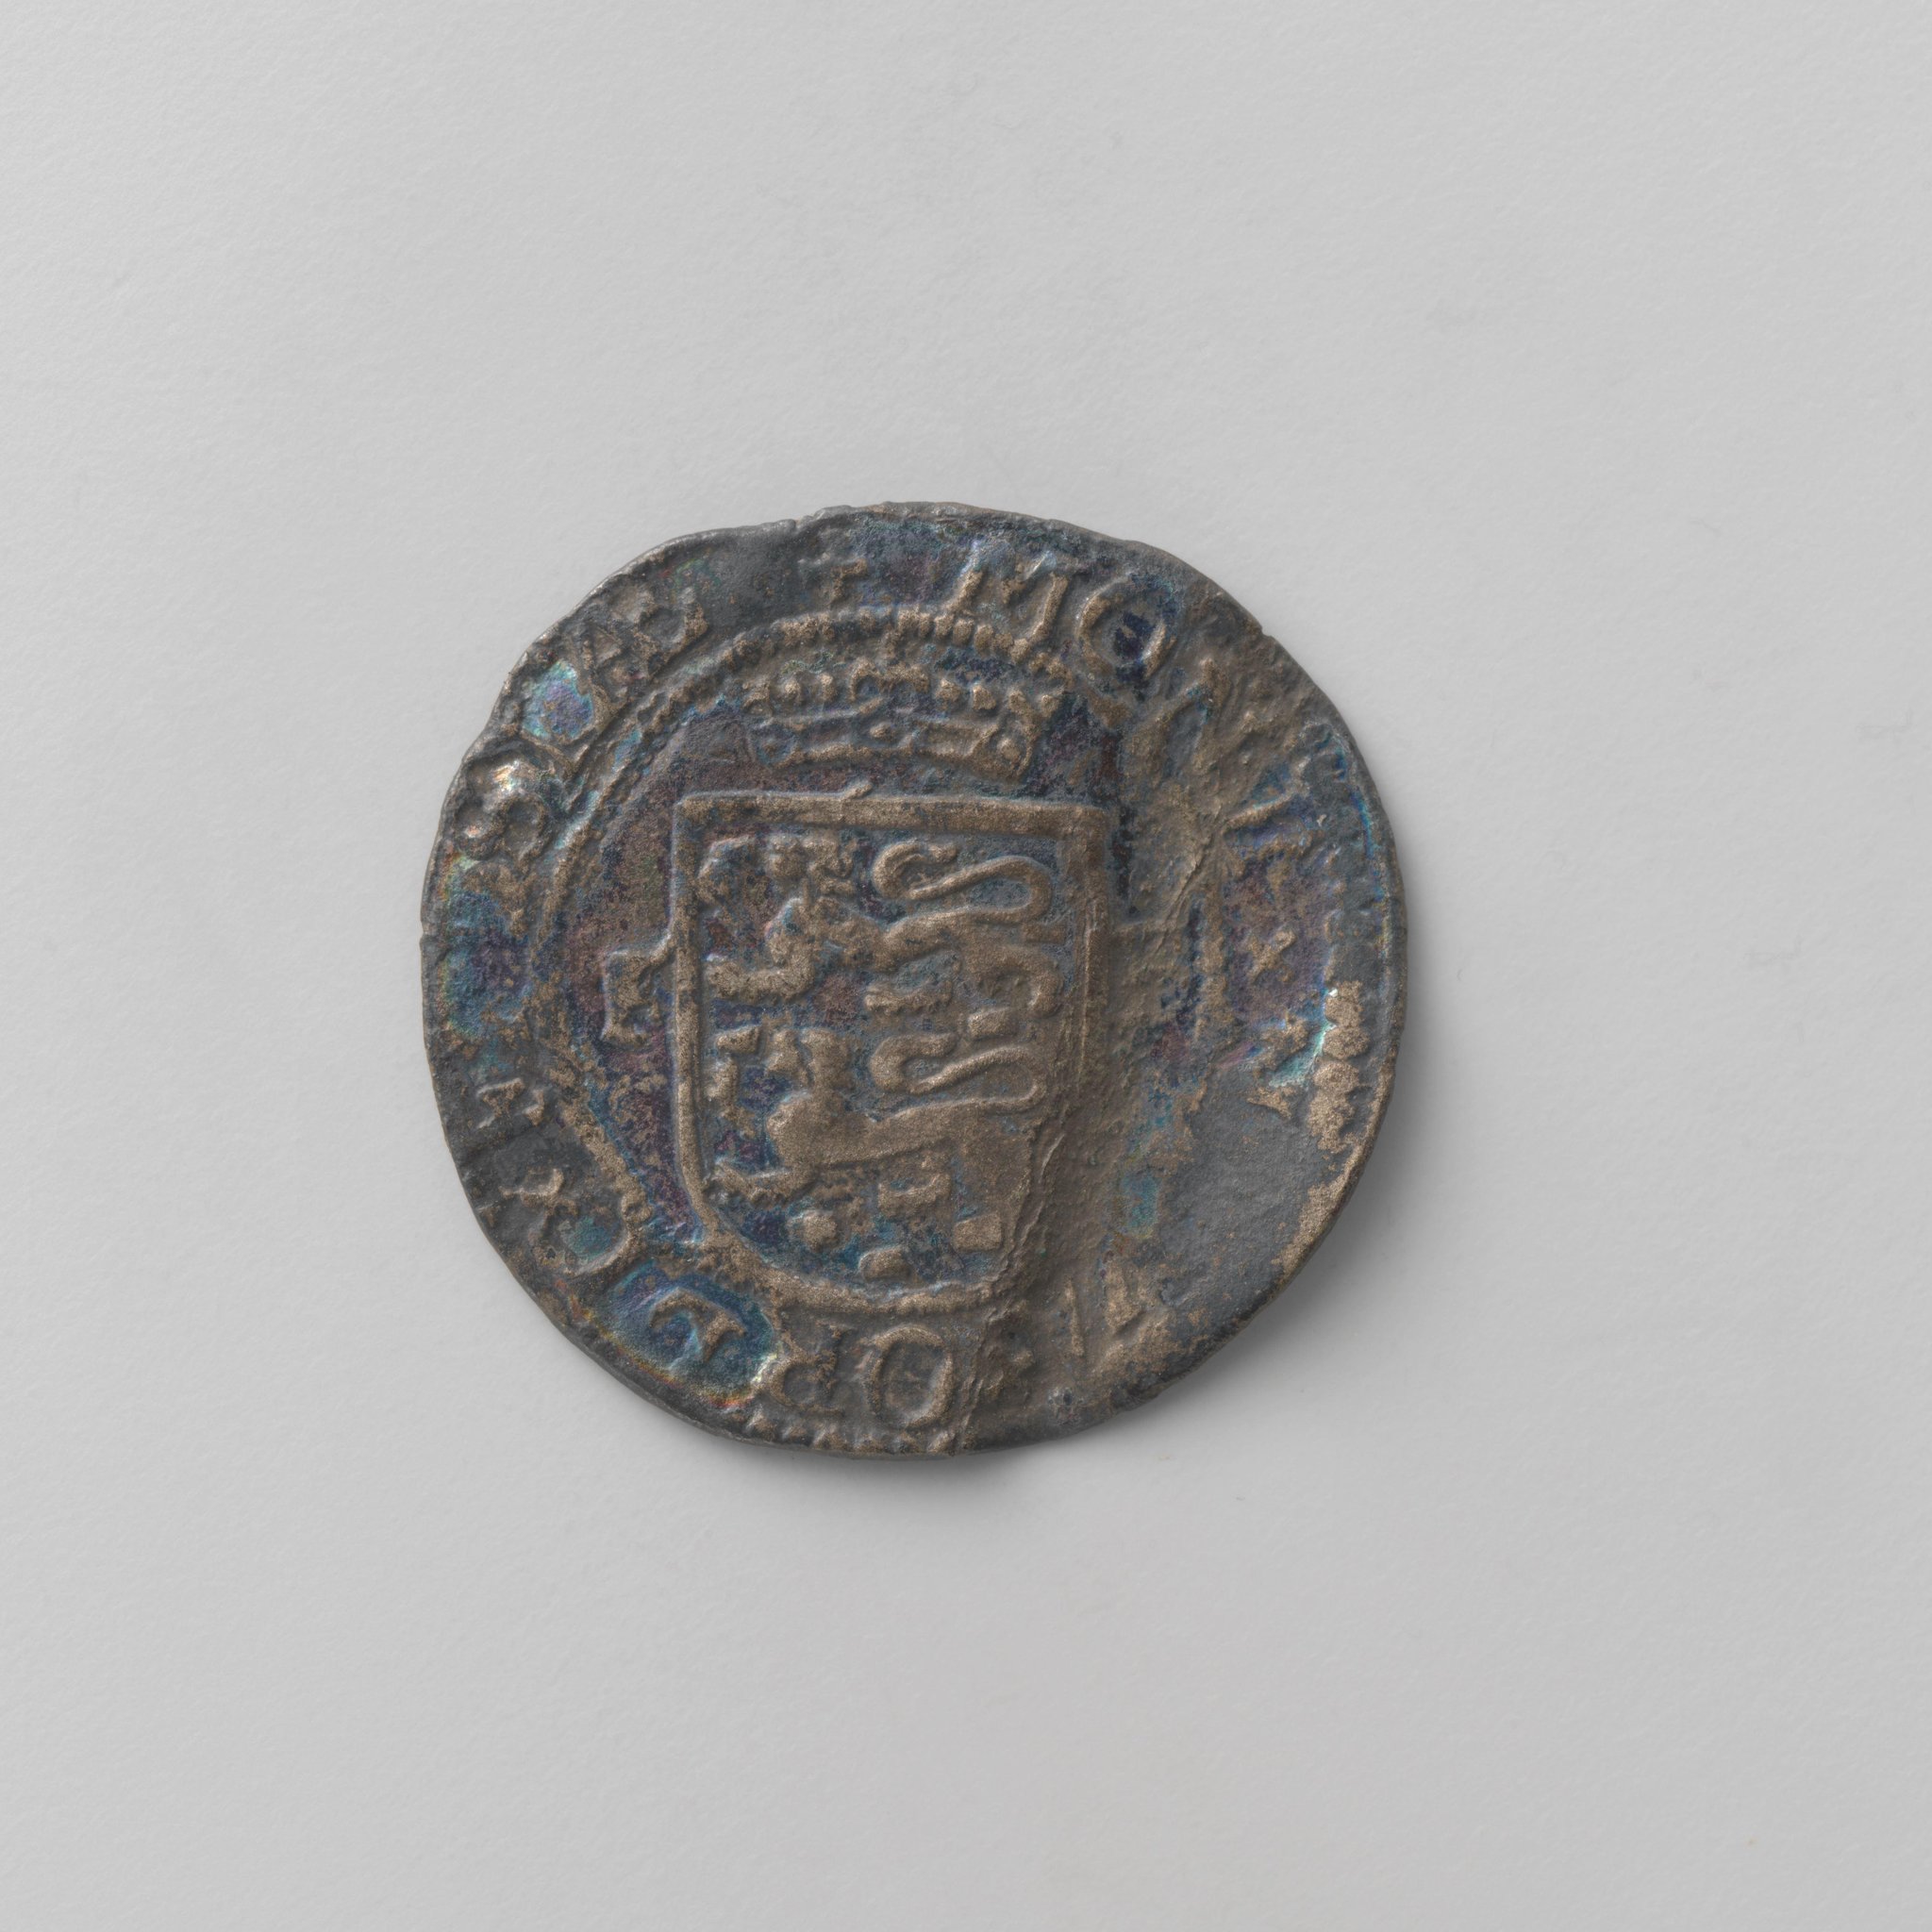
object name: coin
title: Halve stuiver of Fries butken van Friesland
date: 1590-1610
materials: silver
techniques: striking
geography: leeuwarden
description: Koper-zilveren munt. Voorzijde: tussen waarde-aanduiding F B gekroond wapenschild van Friesland. Keerzijde: lang dubbellijnig versierd kruis met in hart leeuwtje en in hoeken de letters B, F, B en F.